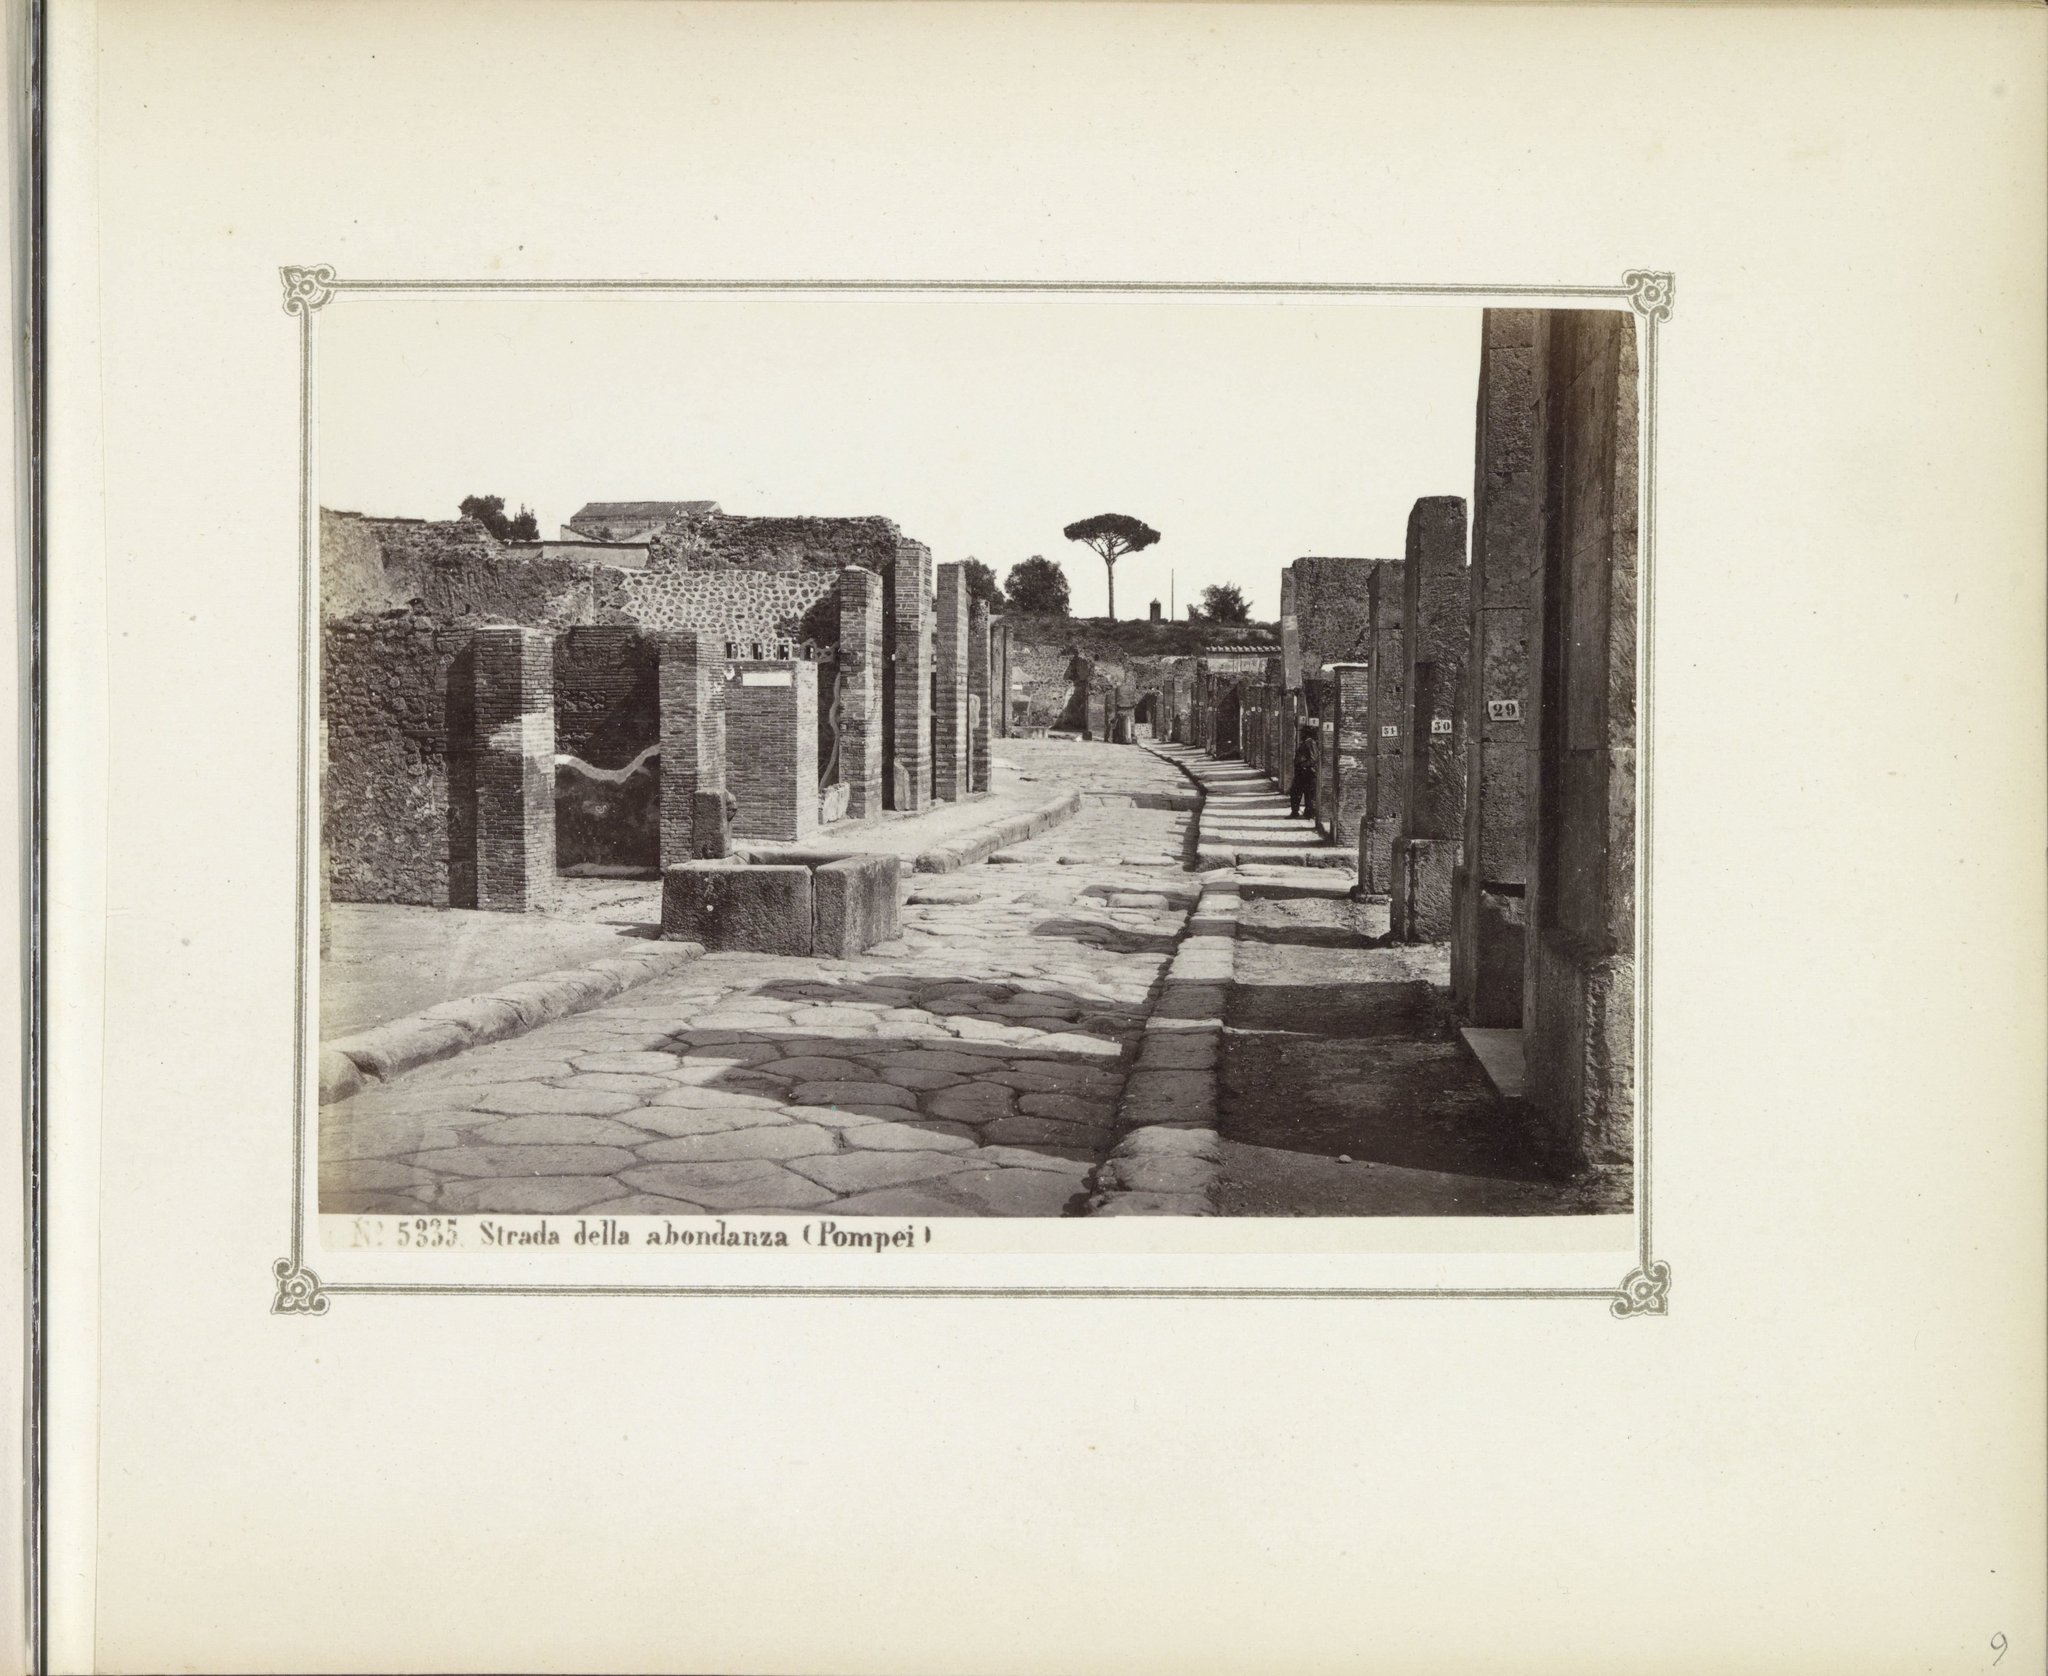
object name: photograph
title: Restanten van gebouwen aan de Strada della Abondanza in Pompeï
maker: giorgio sommer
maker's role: fotograaf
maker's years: 1834-1914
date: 1860-1900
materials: paper, photographic support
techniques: albumen print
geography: pompeii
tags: excavation ~ archaeology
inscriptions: number: ‘5335’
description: Onderdeel van Fotoalbum met opnames van opgravingen in Pompeï door Giorgio Sommer.